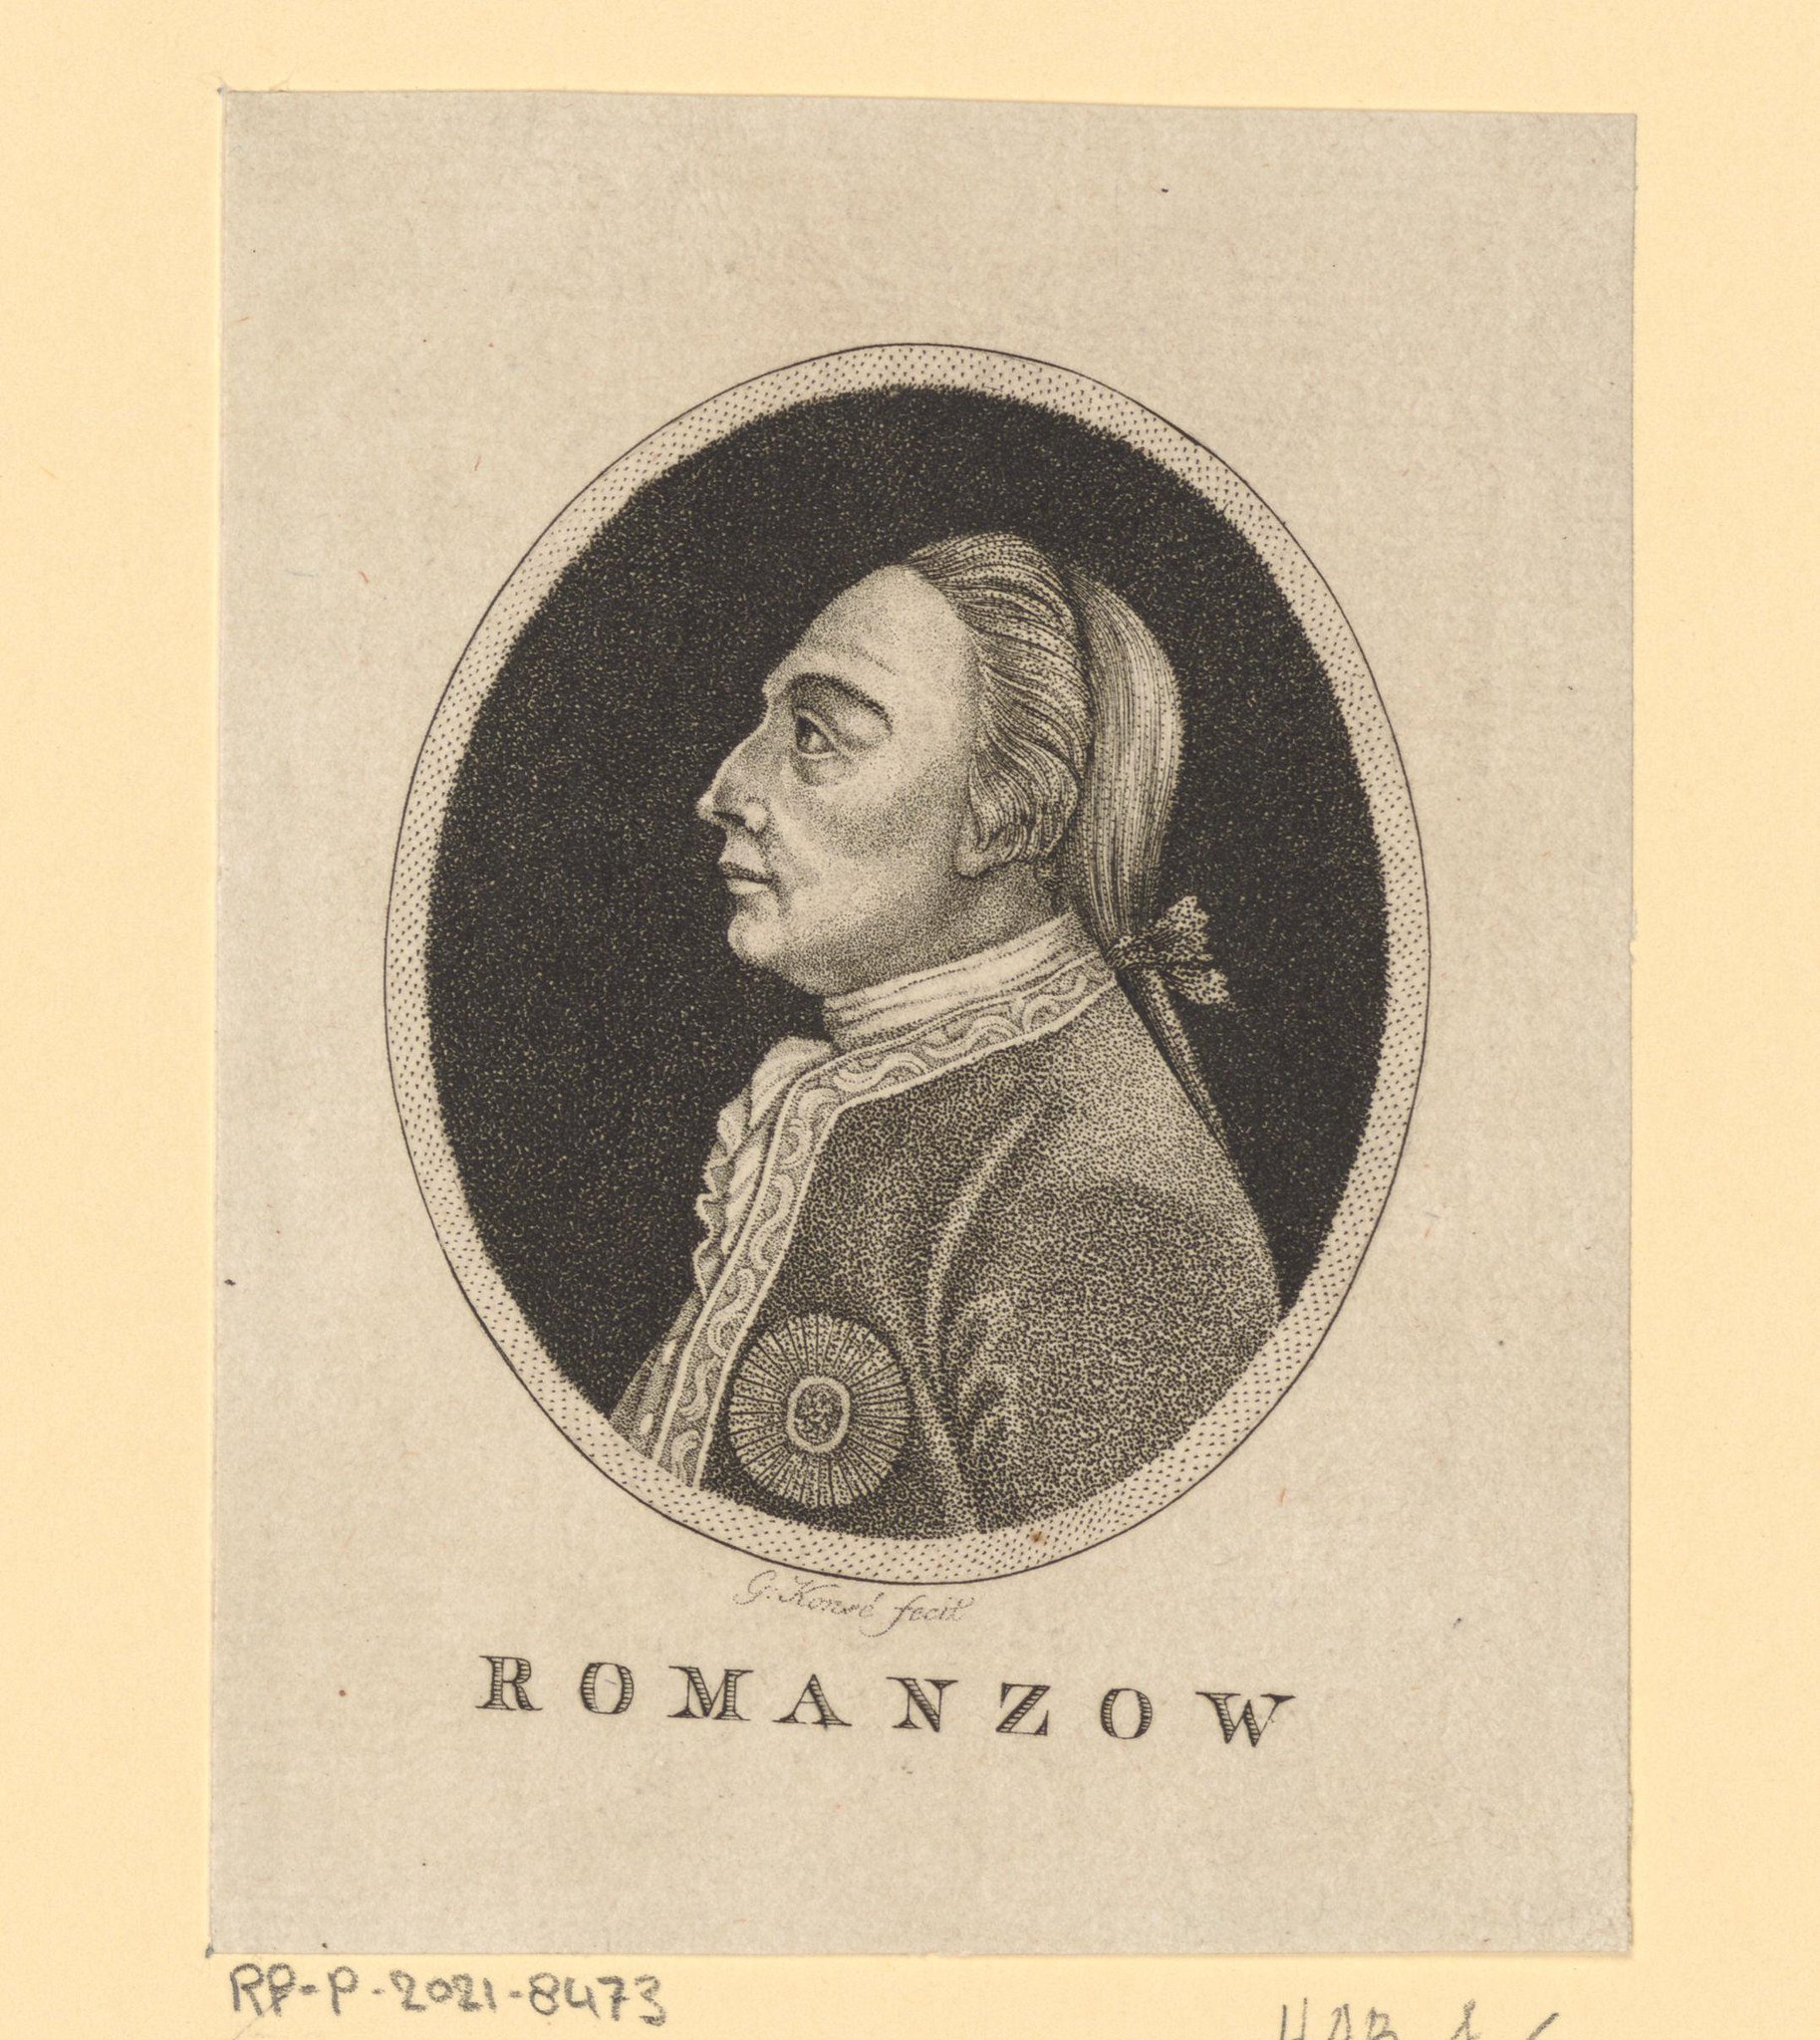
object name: print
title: Portret van Nikolaj Roemjantsev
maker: gerrit konsé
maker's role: print maker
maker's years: 1751-1826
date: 1761-1826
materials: paper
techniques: engraving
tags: nikolaj roemjantsev, historical persons